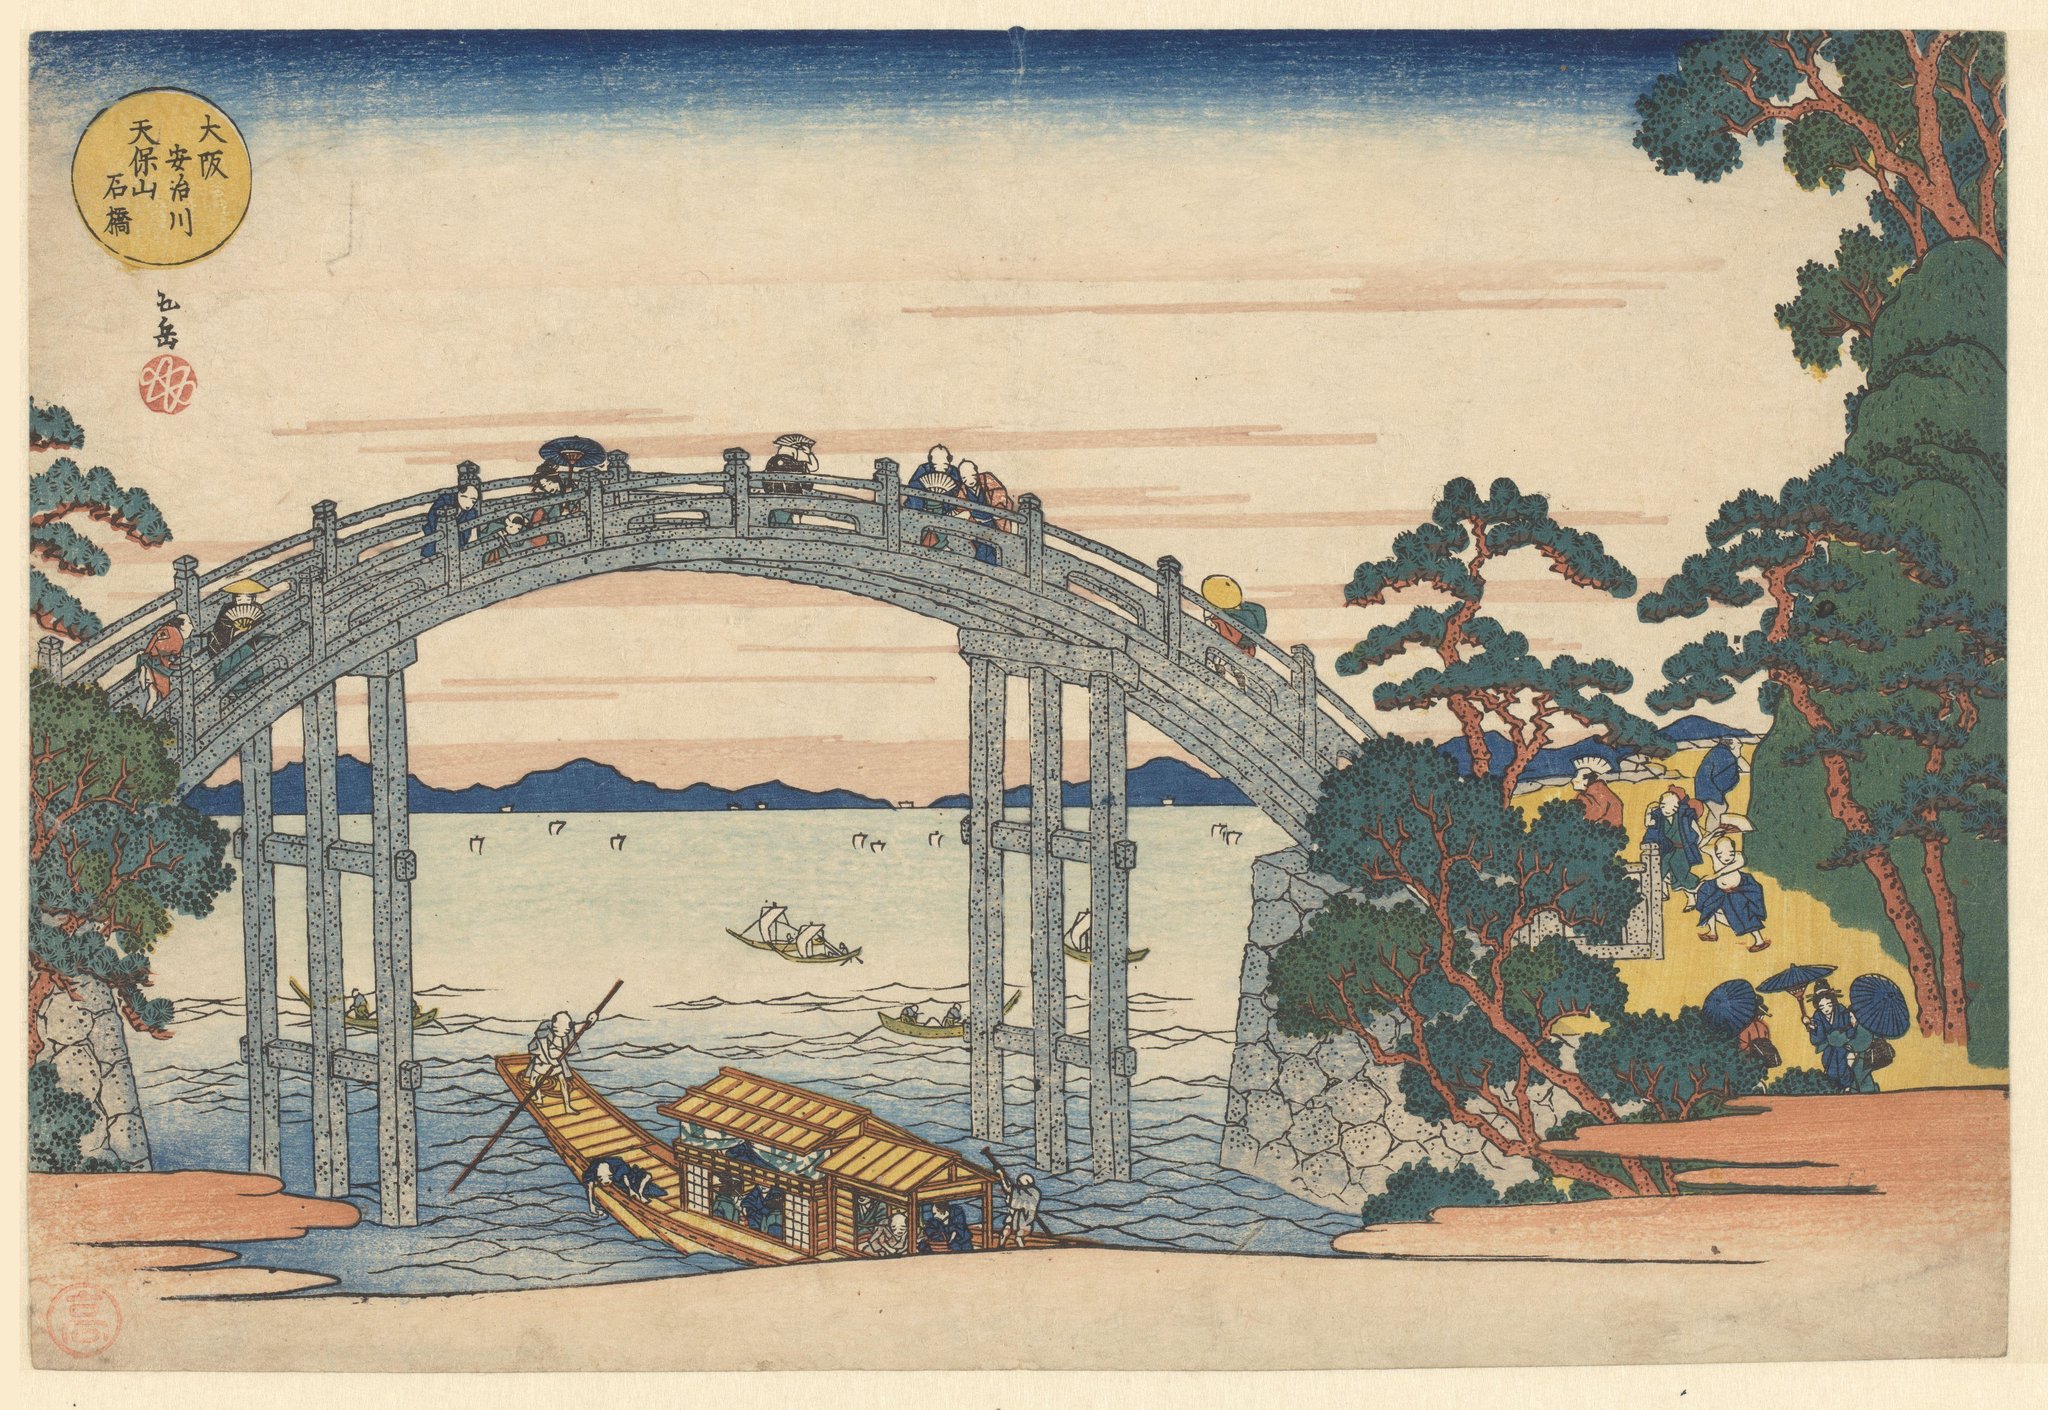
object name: album leaf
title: De stenen brug bij de Tenpo berg en de Aji rivier in Osaka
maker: yashima gakutei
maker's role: print maker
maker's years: 1786-1868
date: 1834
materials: paper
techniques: woodcut, nishiki e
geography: japan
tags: landscape with bridge, viaduct or aqueduct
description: Gezicht op een hoge stenen brug over een rivier uitmondend in een breed meer met bootjes; op de brug mensen, over de reling naar de boten benenden kijkend.